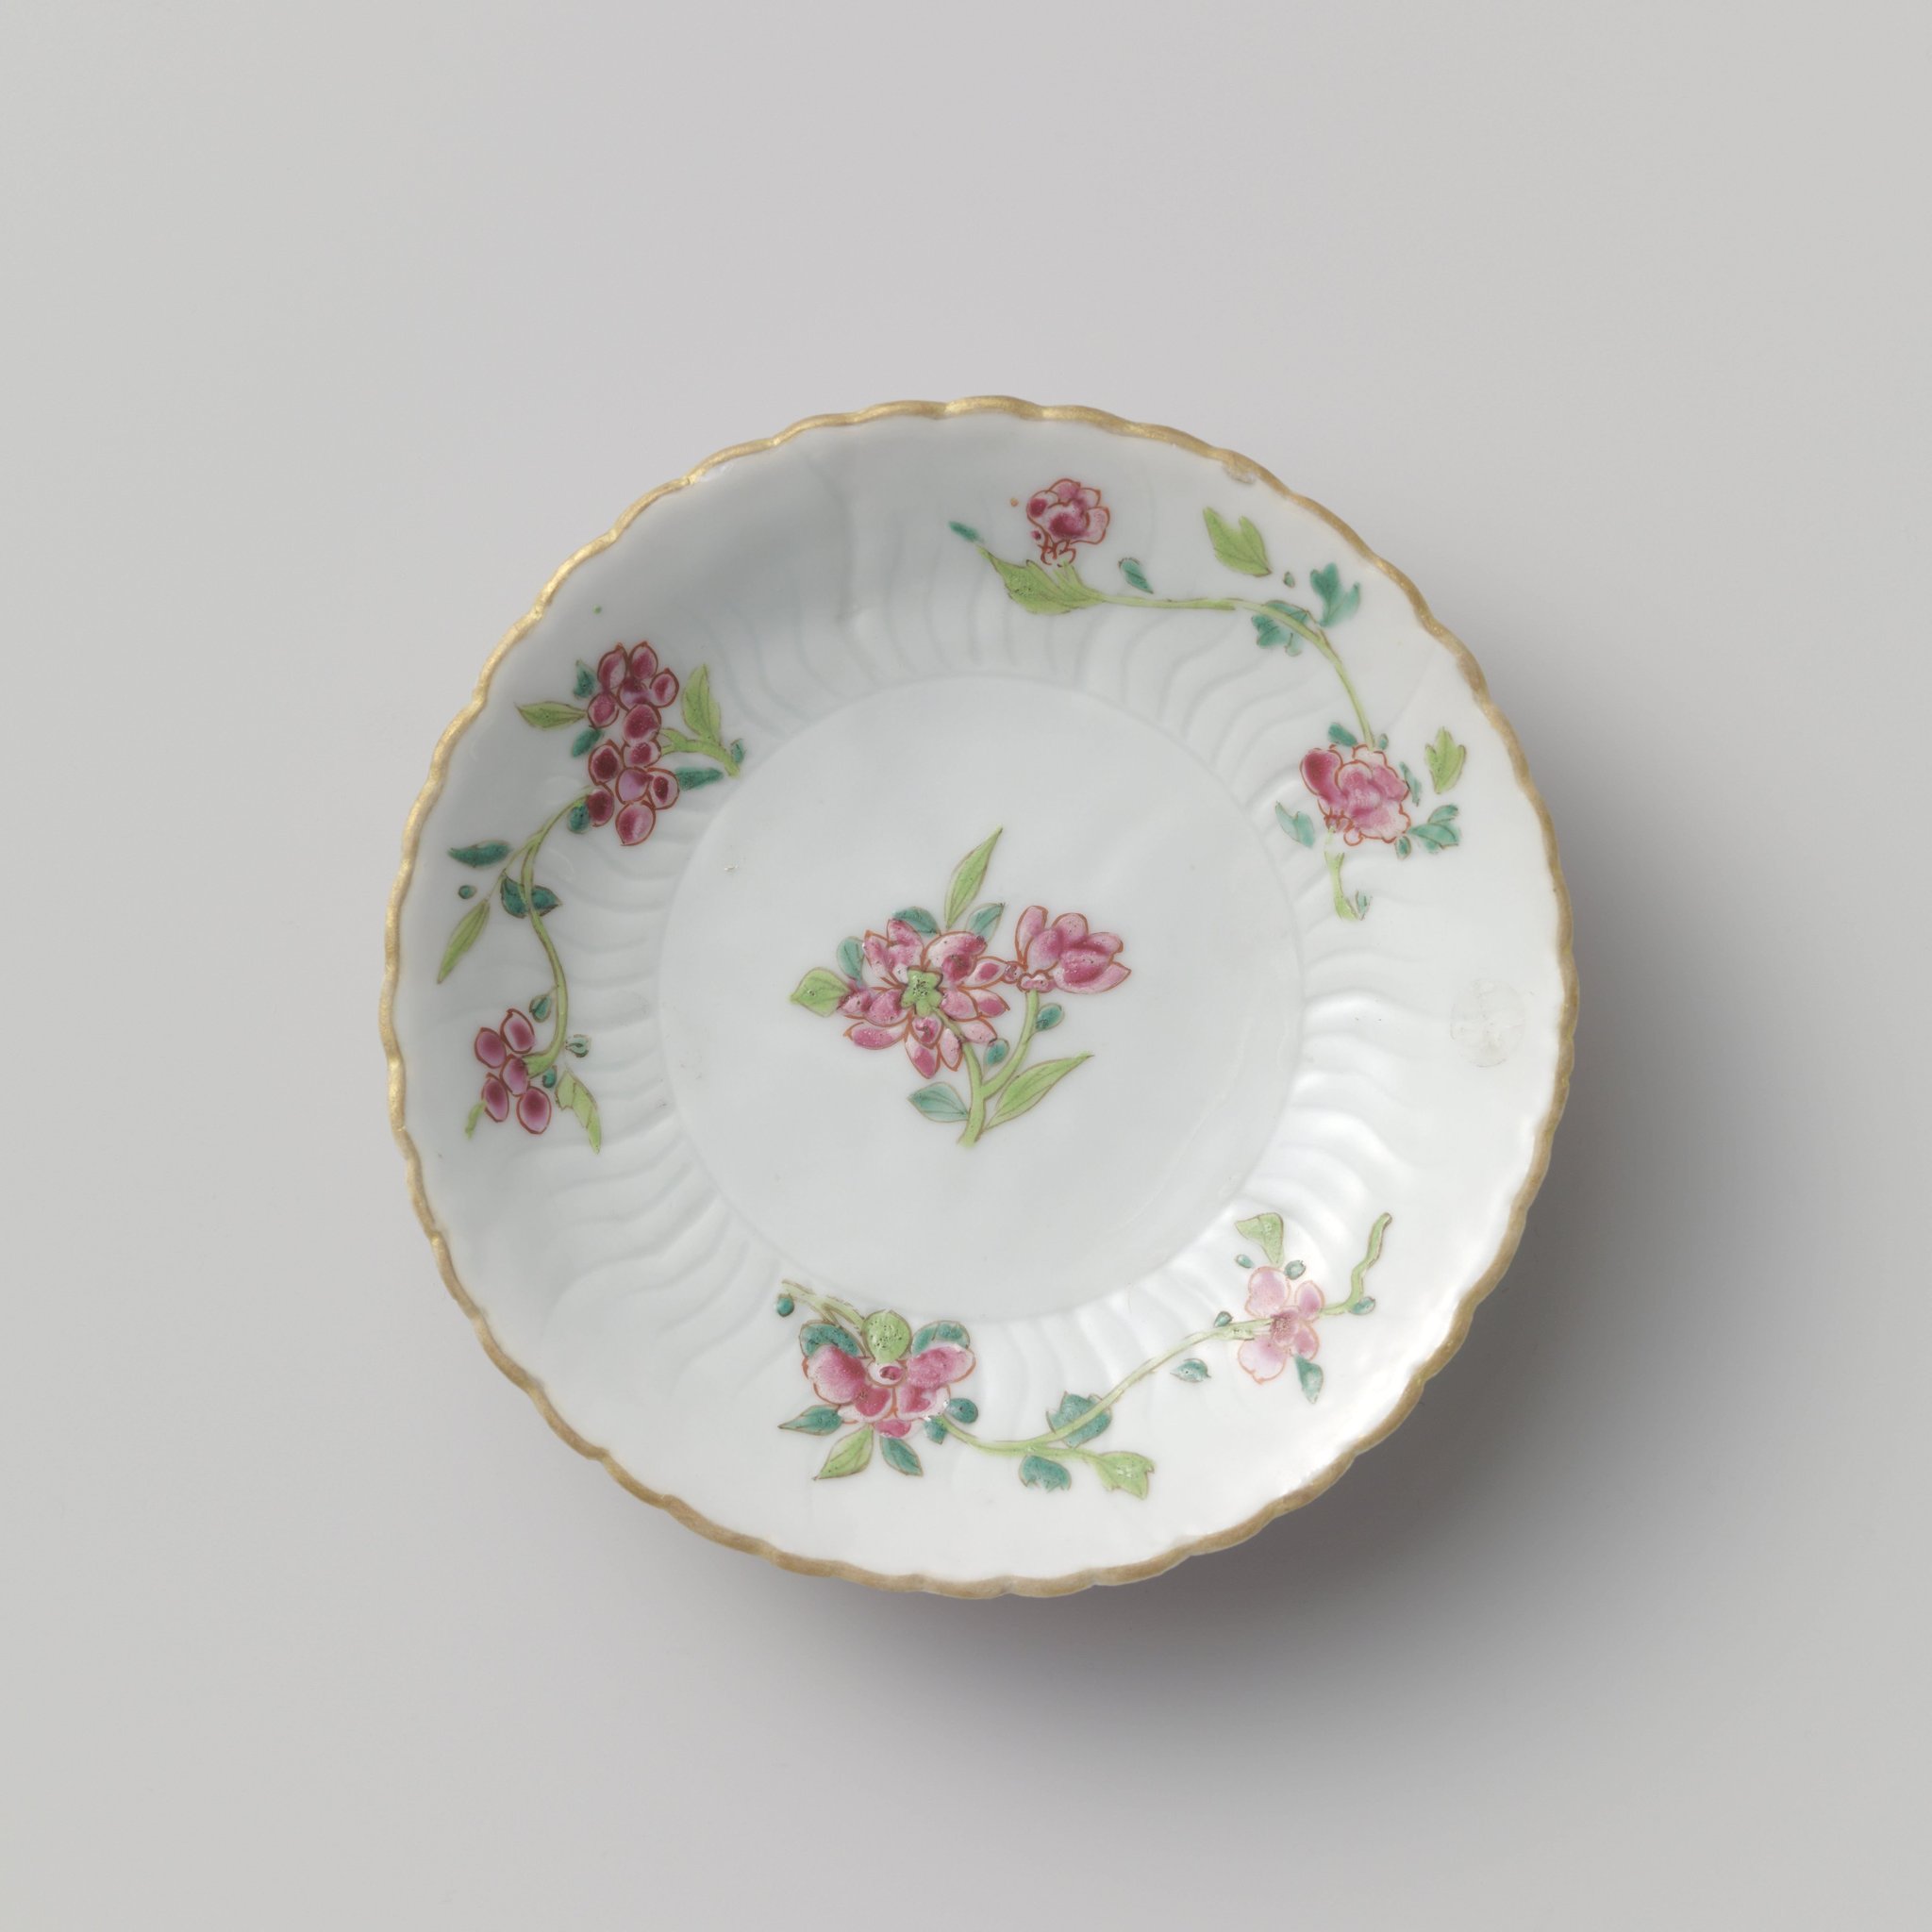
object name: platter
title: Saucer in the shape of a flower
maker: Anonymous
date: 1740-1760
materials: glaze, gold, paint, porcelain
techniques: firing, forming, gilding, turning, vitrification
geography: china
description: AK-NM-6406 en 6407 Zes koppen en schotels • Famille rose porselein • Onderdeel van Royers porseleincollectie • Mogelijk afkomstig van Susanna Louise Huygens De koppen en schotels zijn gevormd als zich openende bloemblaadjes en de stengels en blaadjes vormen de voet van de schotels. Het navolgen van elementen uit de natuur kwam bij het vormen van keramiek in China vaker voor. Royer had daar zelf voorbeelden van bij zijn Yixing theepotten (AK-NM-6568 en -6580 bijvoorbeeld) en bij zijn blanc de Chine porselein (de bakjes AK-NM-6534). Dit soort theegoed dat in vrij veel andere collecties ook te vinden is en waar dus blijkbaar enthousiasme voor bestond onder de Europese kopers, volgt hetzelfde principe, maar is verder gestandaardiseerd en – mede door de beschildering – een tikje kitschiger [Wirgin 1998, nr. 93]. Opvallend is dat juist ook in vorstelijke collecties deze koppen en schotels te vinden zijn: in Londen, Dresden, Kopenhagen [Ayers 2016, vol. I, nrs. 761-766, Reichel 1993, nr. 28, Grandjean 1965, nr. 12, pl. 28]. Informatie over die vorstelijke collecties helpt bij het dateren. In Dresden werden de kopjes tussen 1727 en 1729 geïnventariseerd en in Kopenhagen hebben ze een monogram van koning Christiaan VI die van 1730 tot 1746 regeerde. Ze zijn dus vroeger dan je zou denken. Royer kon ze waarschijnlijk in 1786 overnemen uit de nalatenschap van zijn oudtante Susanna Louise Huygens (1714-1785). In de beschrijving van haar gekleurde porselein vinden we ‘ses paar thee goed, van buiten rood, schulpwerk, en van binnen marseille met bouquetten, de schoteltjes met geboutzeer rankwerk.’ Deze koppen en schotels horen dus bij de porseleinverzameling. Dit in tegenstelling tot de vele koffie- en theeserviezen en losse series theegoed die volgens de boedelbeschrijving opgemaakt na het overlijden van de weduwe Royer, ergens een plek in huis hadden. Bronnen: Bredo L. Grandjean, Dansk Ostindisk porcelaen importen fra Kanton ca. 1700-1822, Kopenhagen, 1965. Friedrich Reichel, Die Porzellansammlung Augusts des Starken: Porzellankunst aus China, die rosa Familie, München, 1993. Jan Wirgin, Fran Kina till Europa. Kinesiska konstföremal fran de ostindiska kompaniernas tid, Stockholm, 1998. John Ayers, Chinese and Japanese works of art in the collection of Her Majesty The Queen, Londen, 2016.